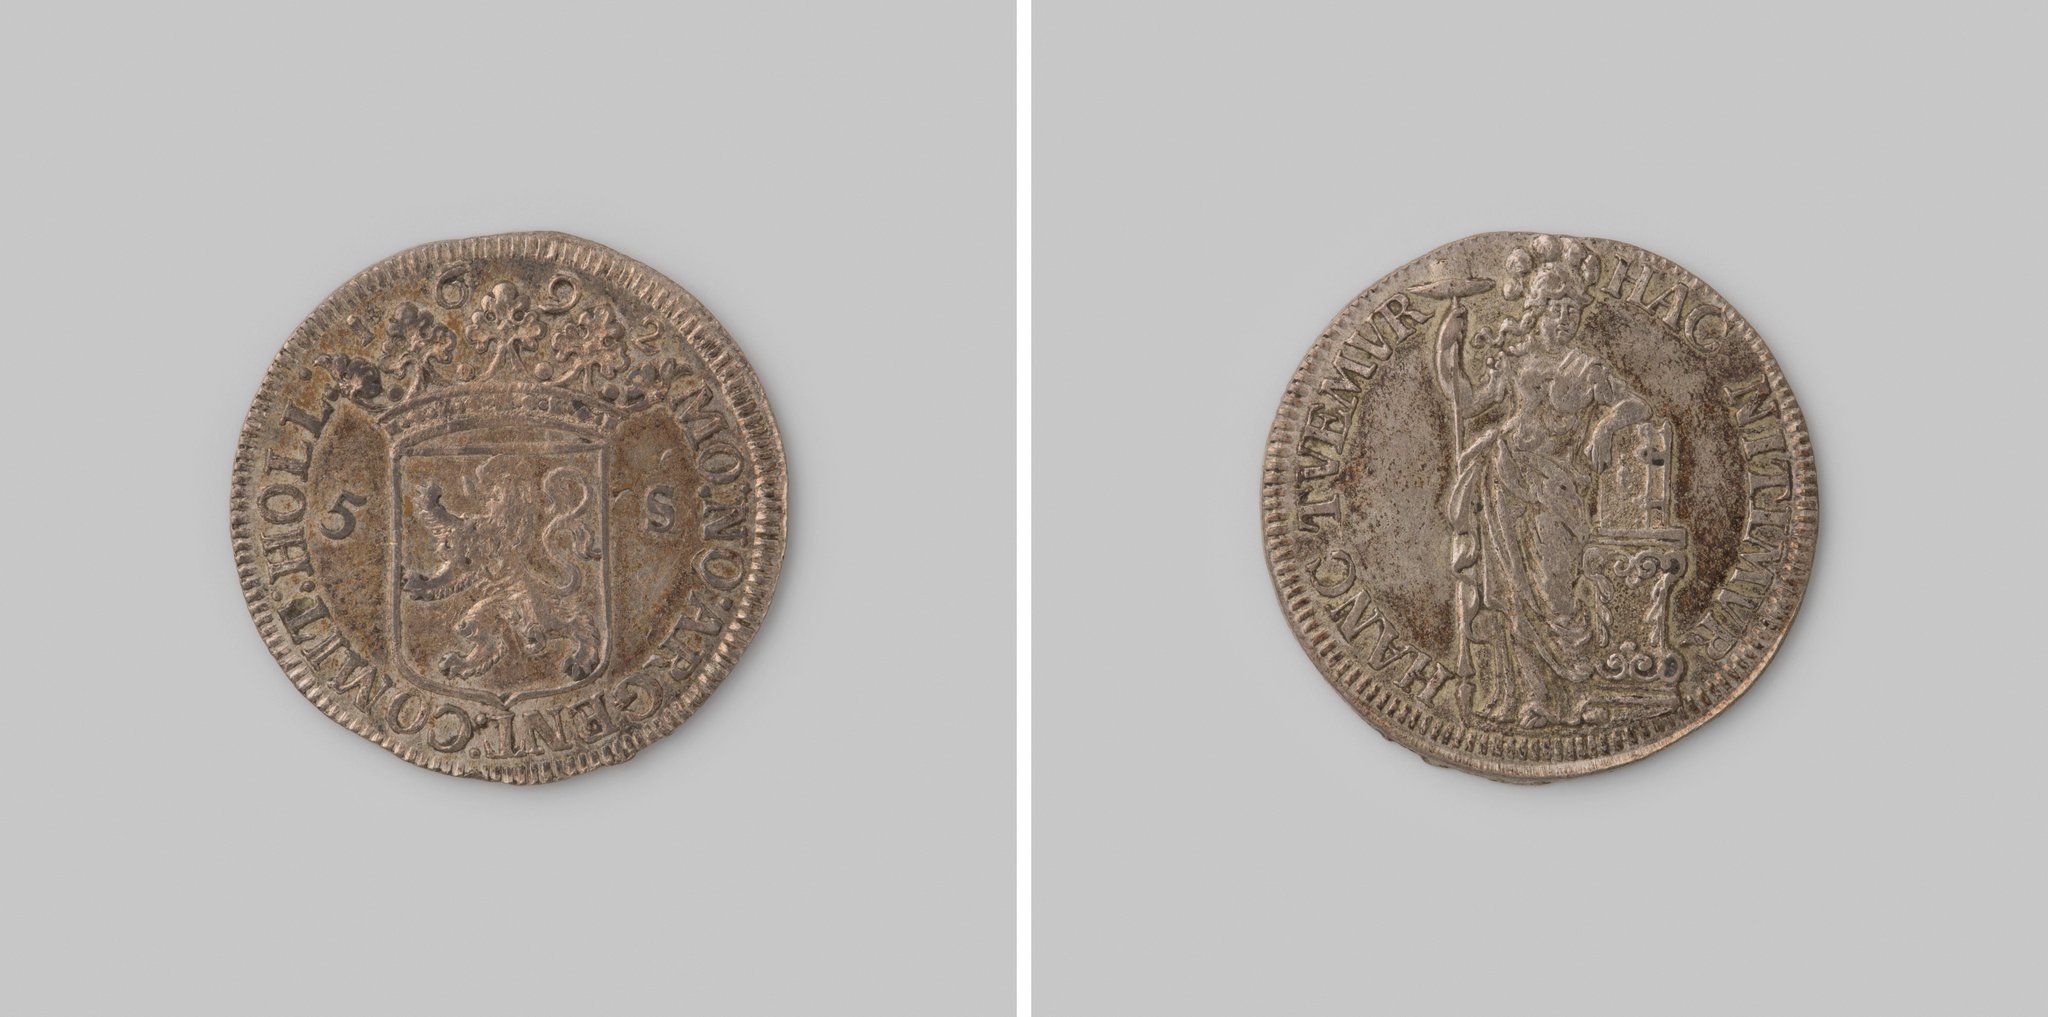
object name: coin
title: Hollandse provinciale kwart gulden, 1692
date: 1692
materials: silver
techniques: striking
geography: dordrecht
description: Zilveren munt. Voorzijde: tussen waarde-aanduiding 5 S gekroond wapenschild van Holland. Boven kroon jaartal. Keerzijde: staande Nederlandse maagd met in rechterhand speer, waarop hoed en met linkerhand steunend op altaar, waarop bijlbel.